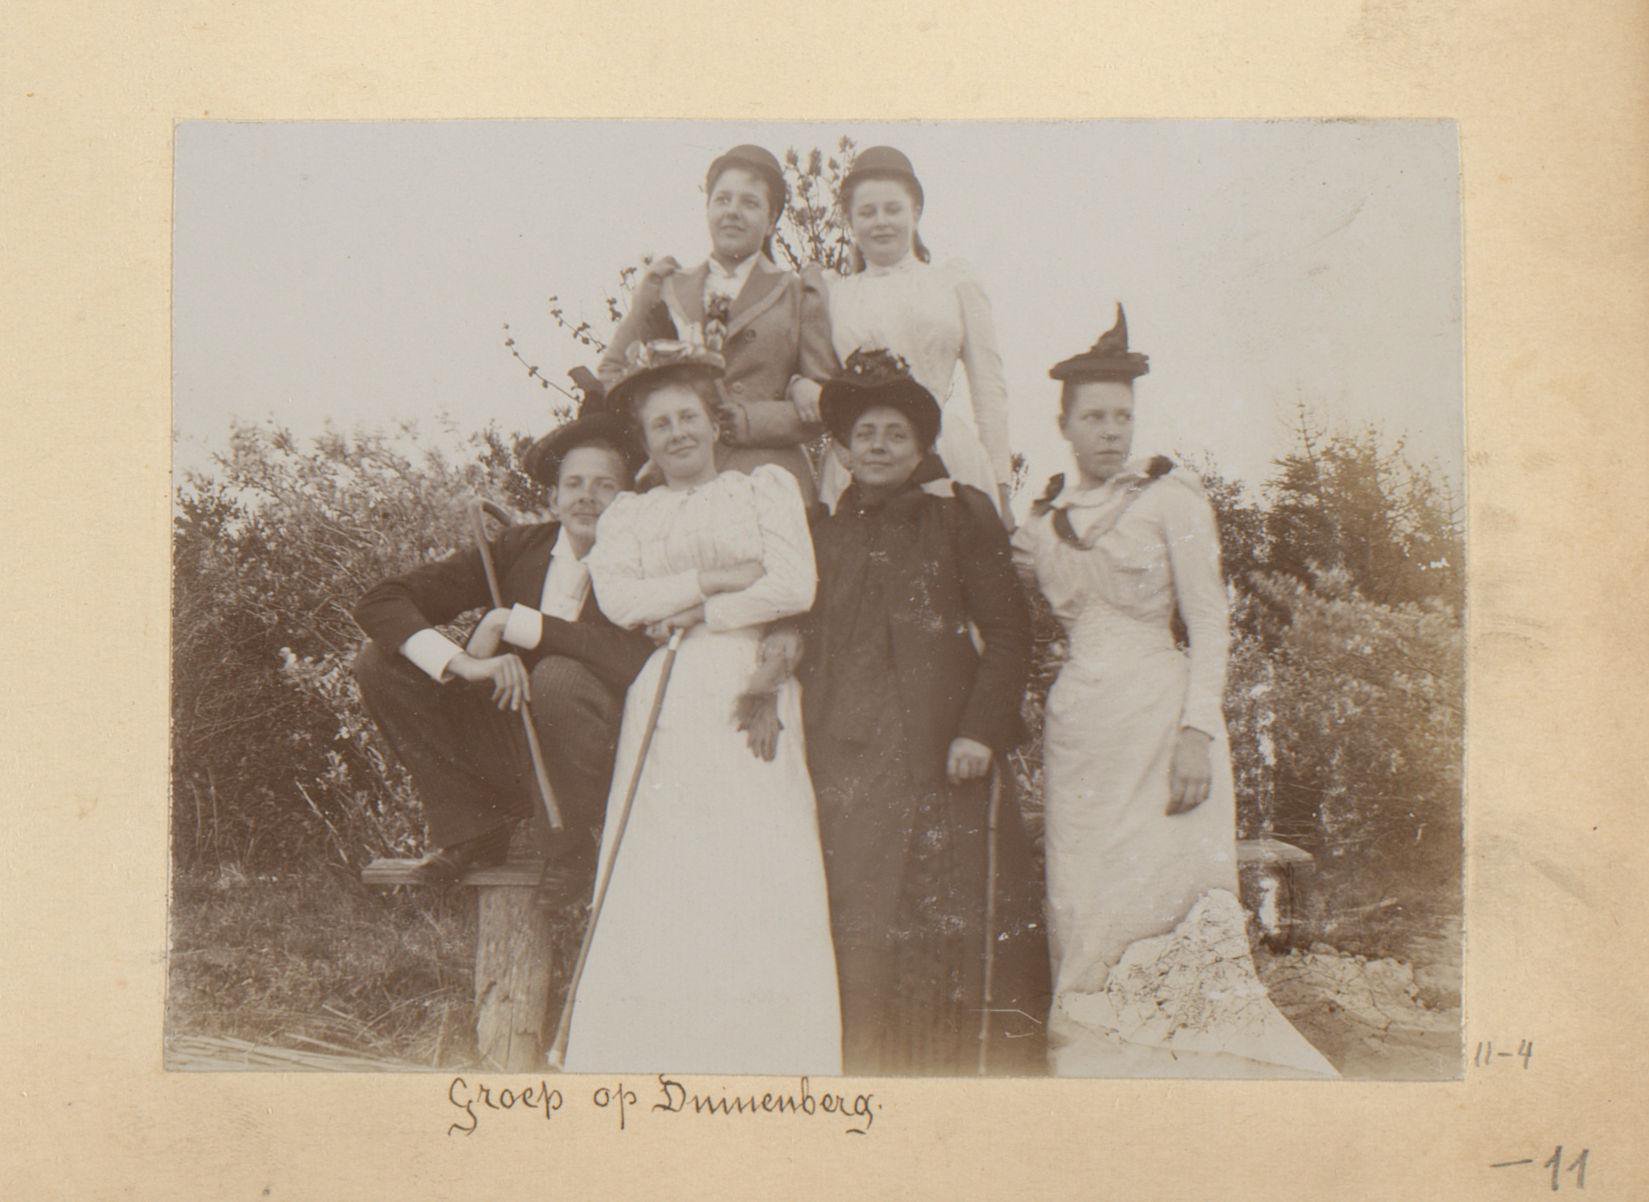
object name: photograph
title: Groepsportret te Duinenberg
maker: hendrik herman van den berg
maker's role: amateurfotograaf, jurist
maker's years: 1875-1944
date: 1890-1894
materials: paper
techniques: collodion silver print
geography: velsen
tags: karel frederik van den berg, java, london, batavia, historical persons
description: Foto 4 op albumblad 11 uit album "Amsterdam 1890-1894".